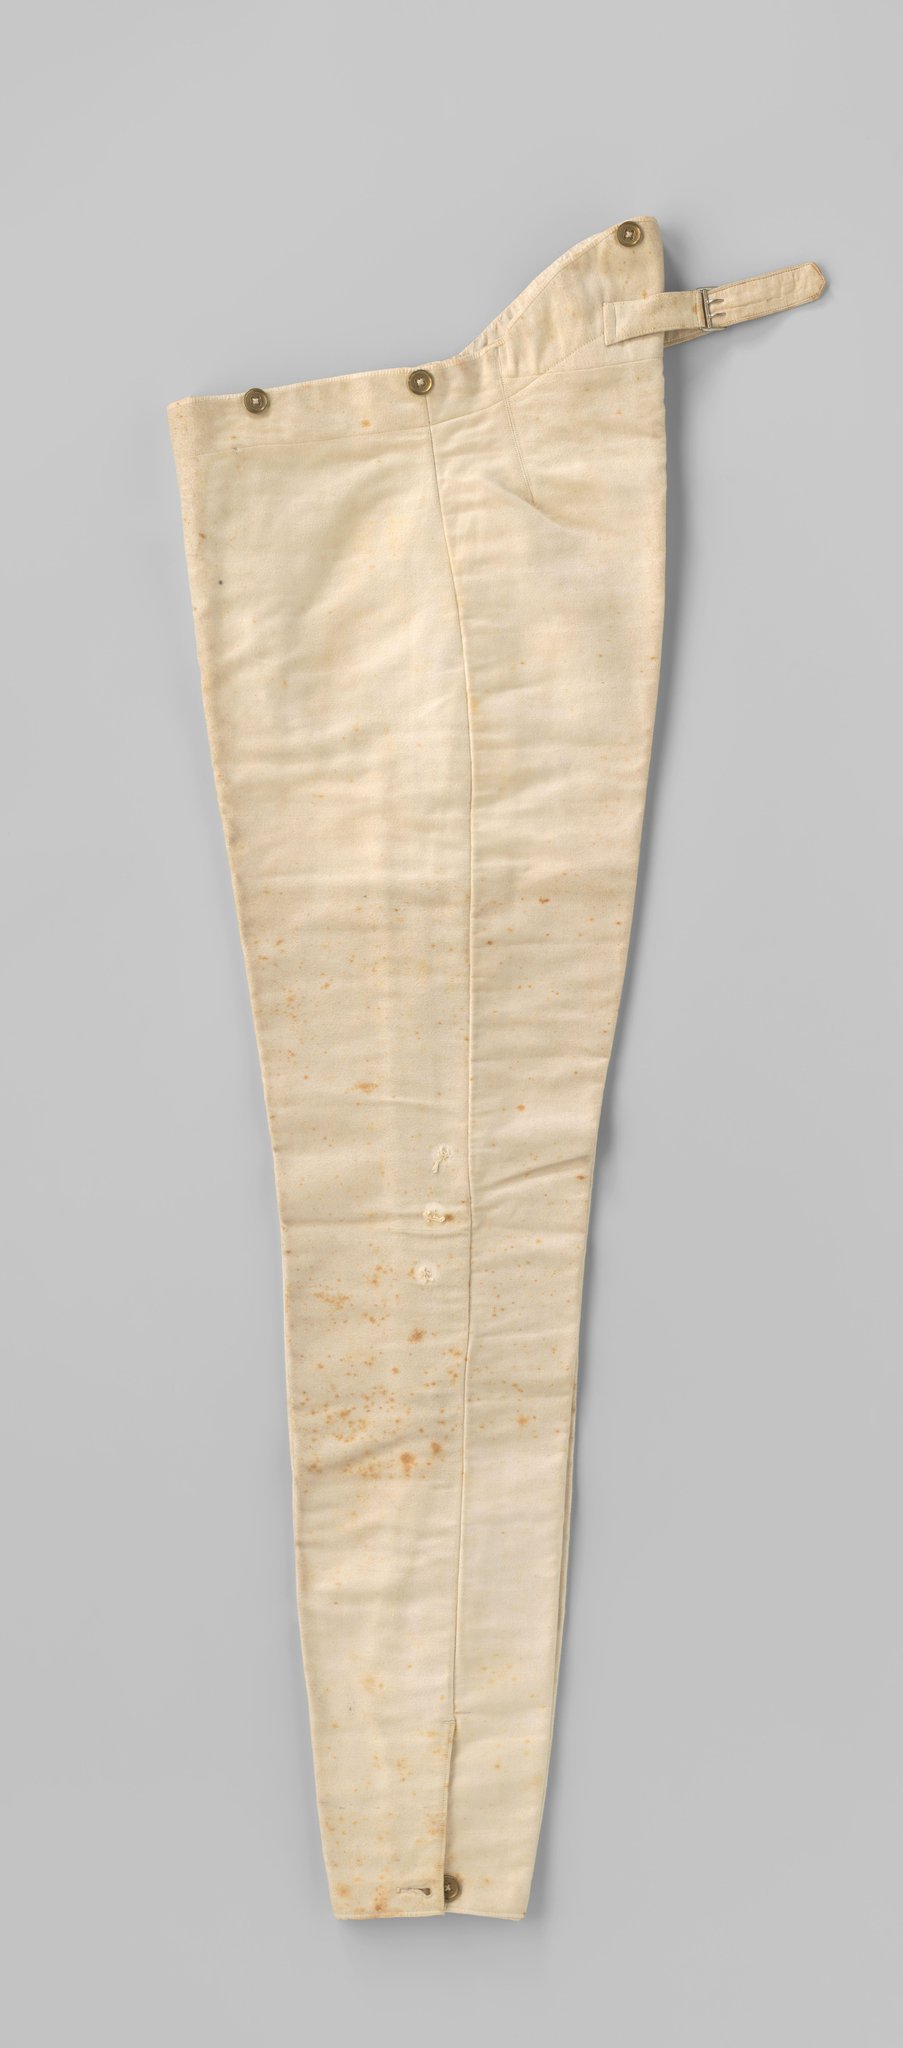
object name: riding breech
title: Beige rijbroek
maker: Anonymous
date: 1813-1814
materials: textile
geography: the hague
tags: amsterdam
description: De gulp sluit met vier koperkleurige knopen. Onder aan beide pijpen een identieke koperkleurige knoop.